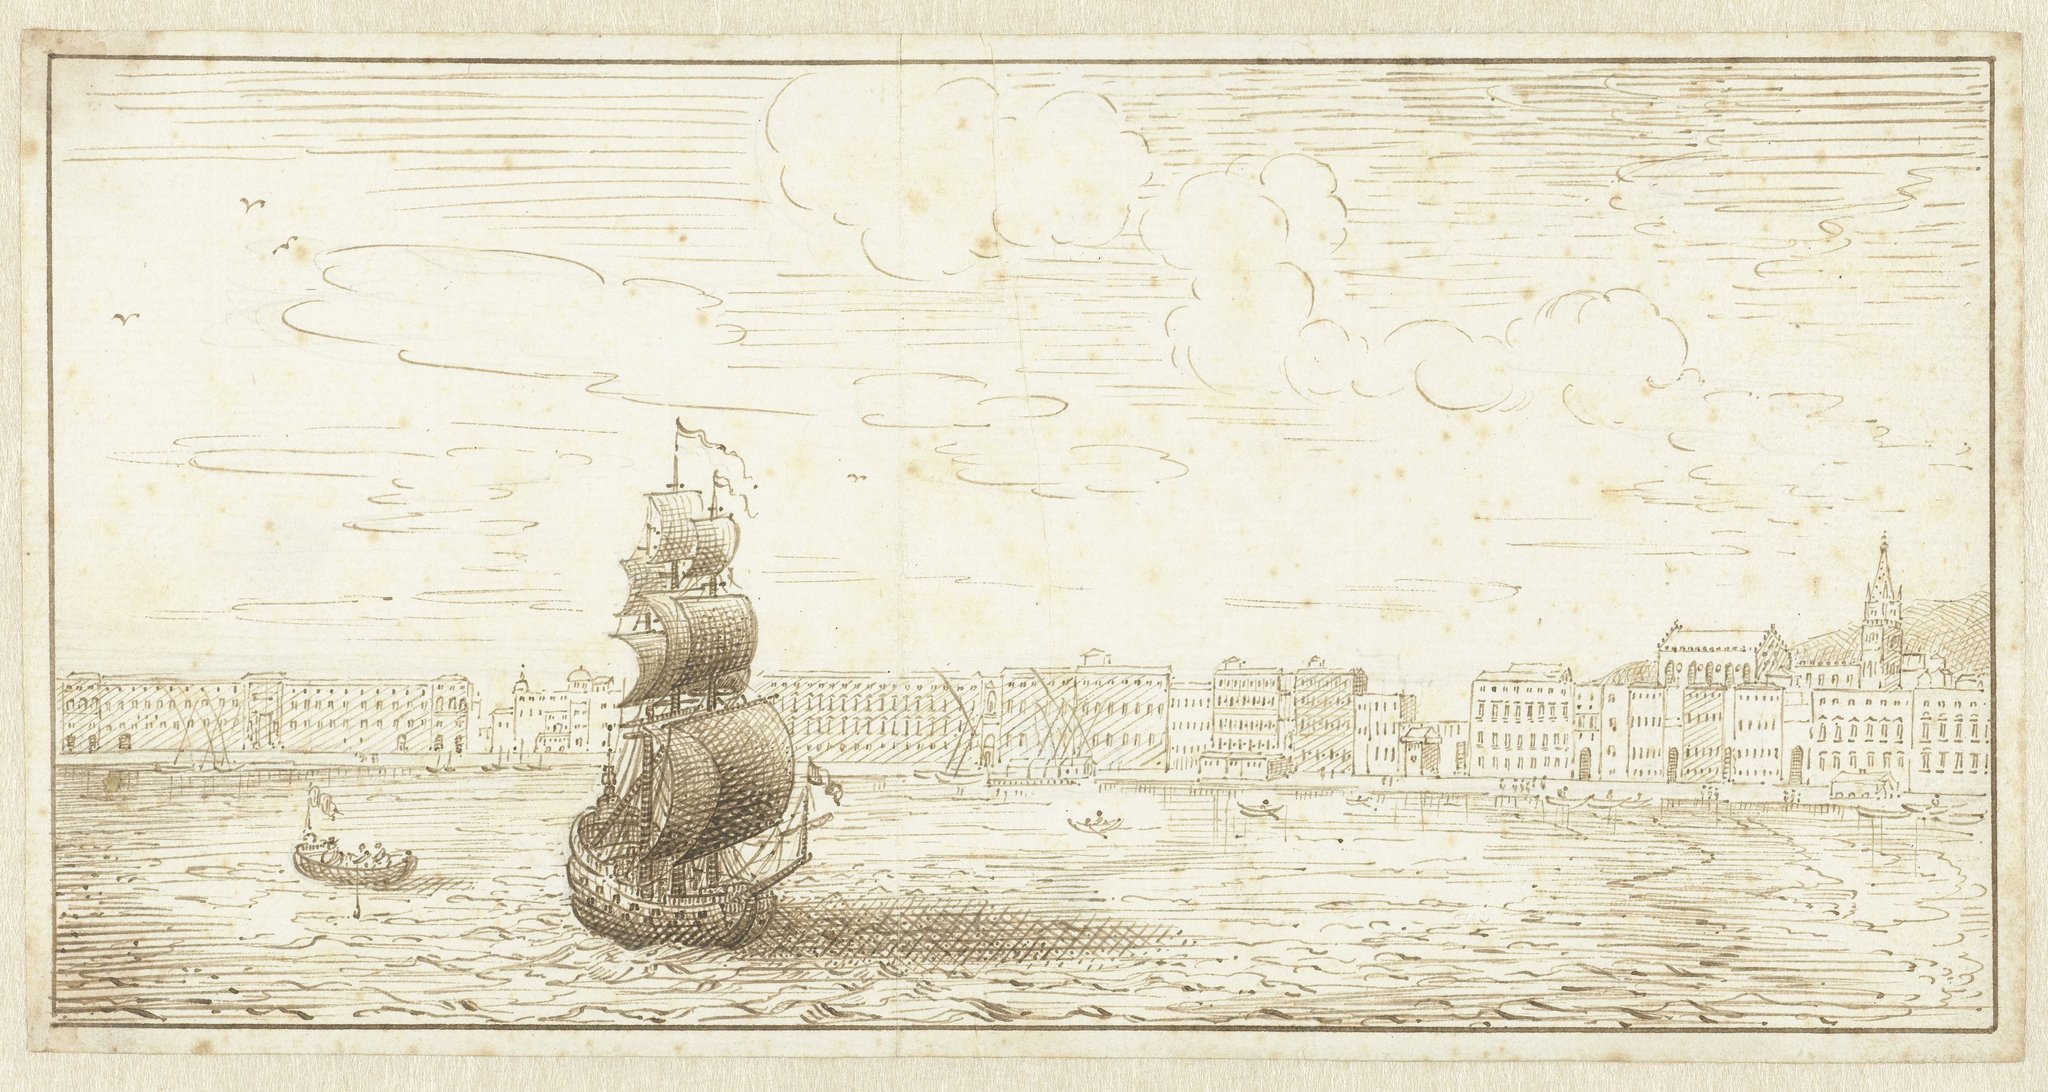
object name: drawing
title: Schip in een baai voor een havenfront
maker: johan teyler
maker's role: draughtsman, print maker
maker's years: 1648-1712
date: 1679-1683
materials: ink, paper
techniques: pen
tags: sailing-ship, sailing-boat, quay